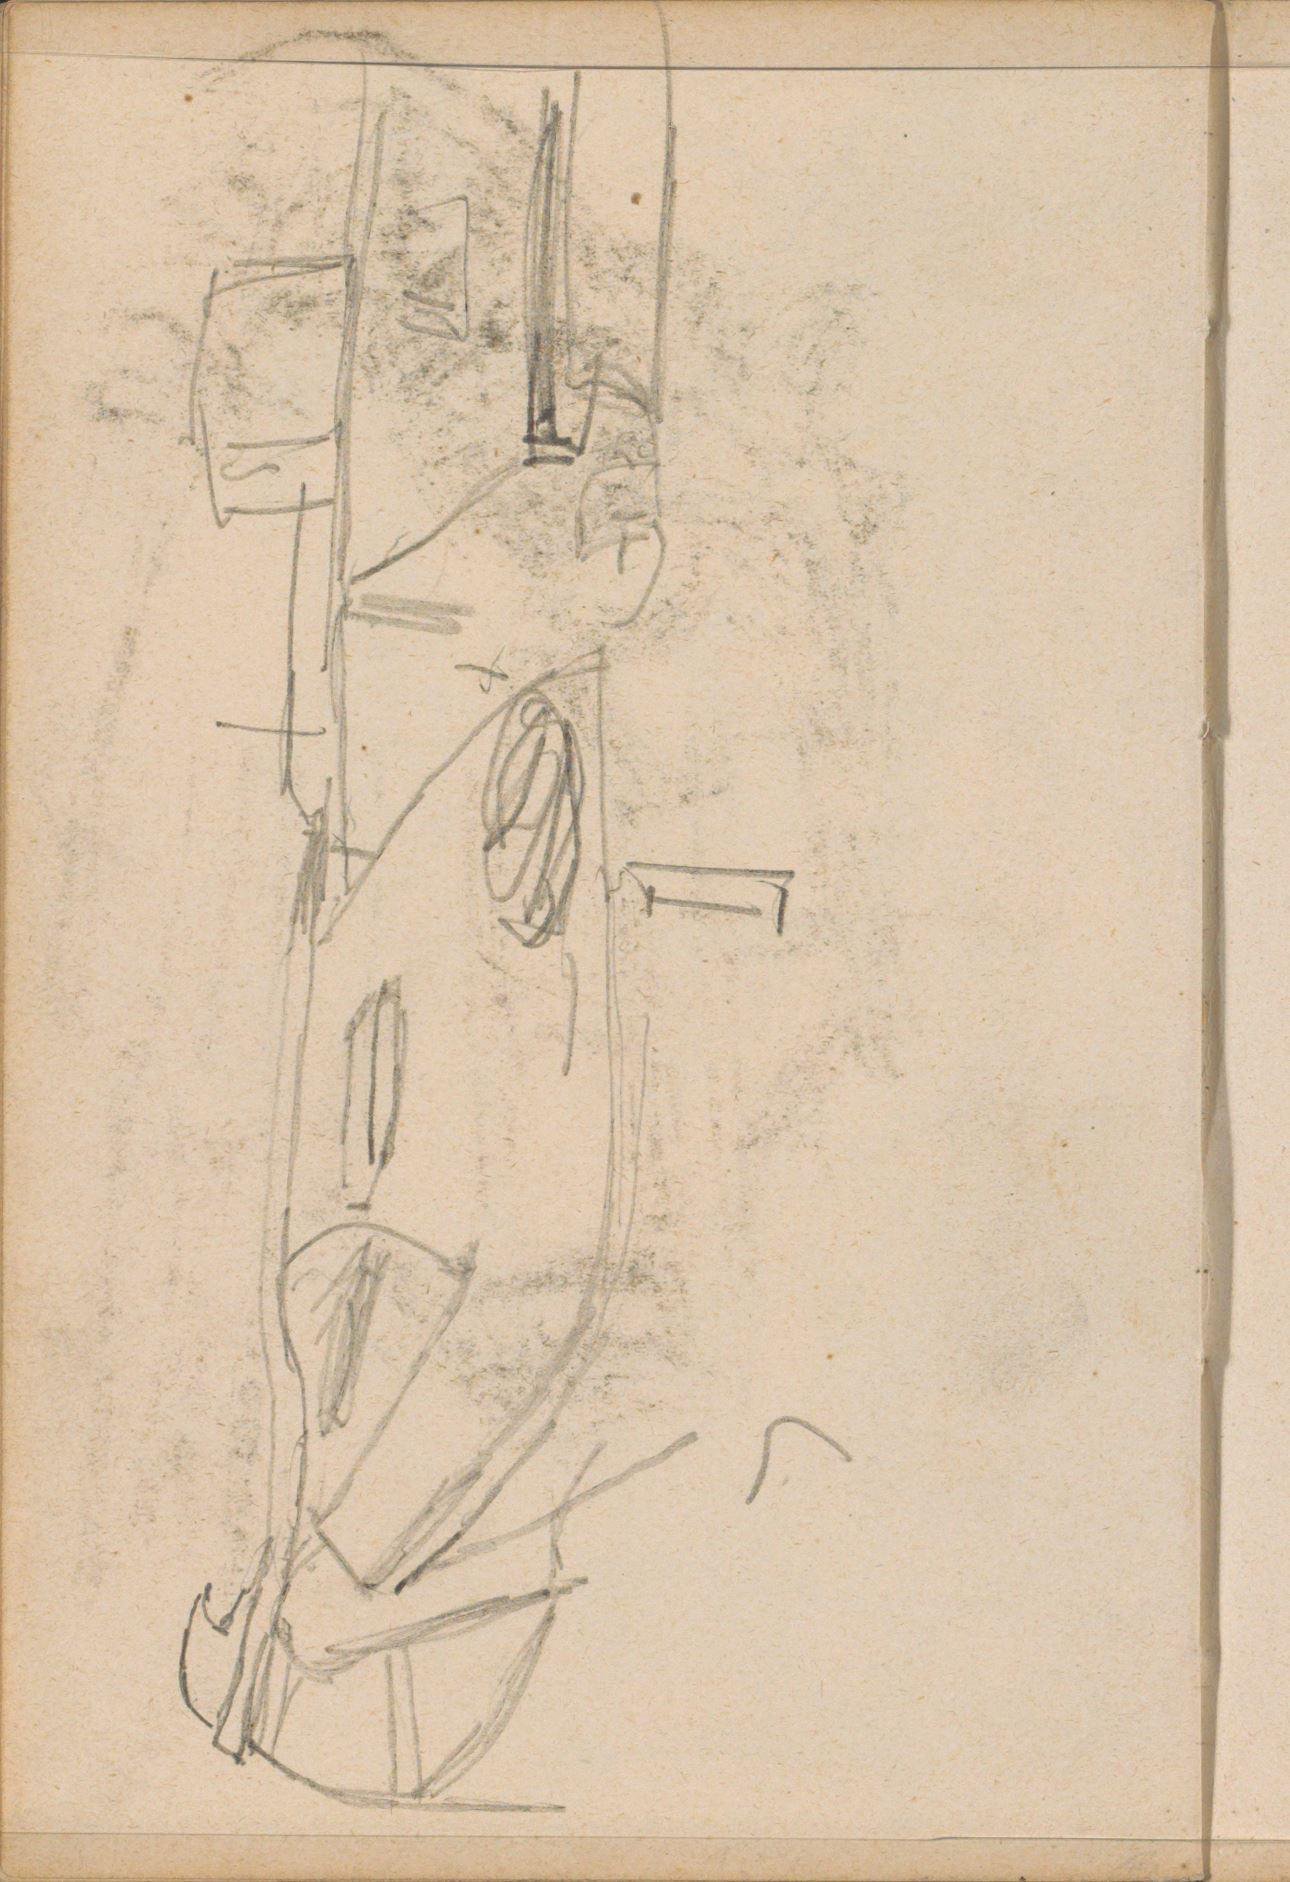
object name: sketchbook leaf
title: Studie, mogelijk van een boot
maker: george hendrik breitner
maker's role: draughtsman, painter, print maker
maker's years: 1857-1923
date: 1909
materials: paper, pencil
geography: amsterdam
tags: boat propelled by man or animal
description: Studie, mogelijk van een boot. Pagina 43 uit een schetsboek met 45 bladen vervaardigd in Amsterdam en Pittsburgh.